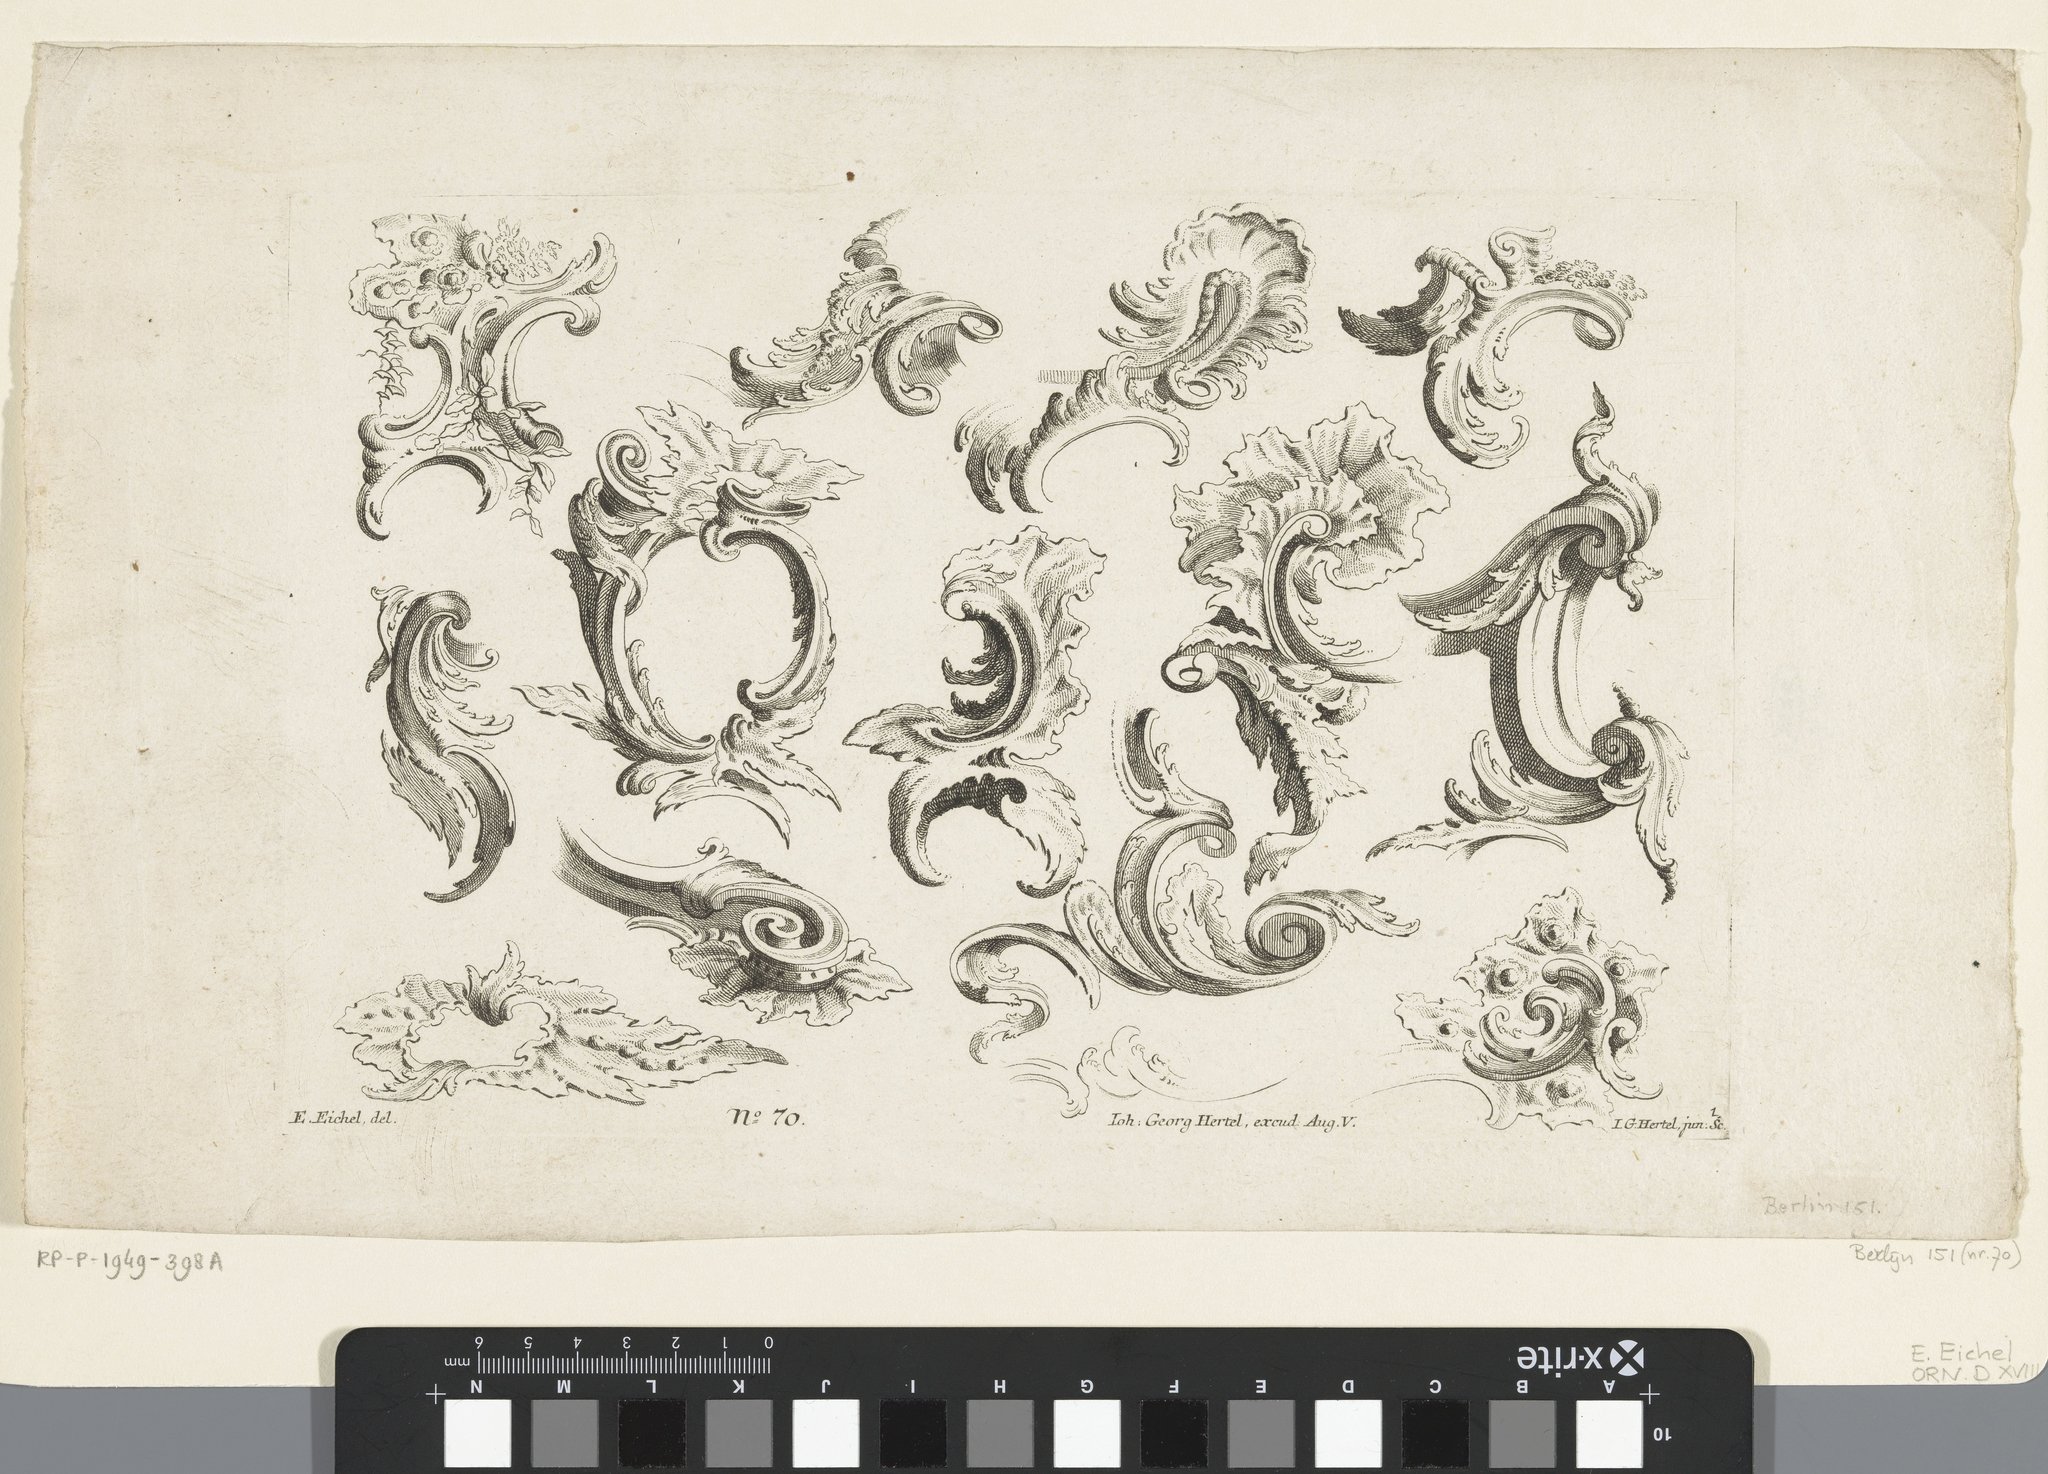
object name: ornament print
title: Voluut- en bladvormige rocaille-ornamenten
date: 1727-1775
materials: paper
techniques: etching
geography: augsburg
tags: rocaille ornament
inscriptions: collector's mark: Lugt 2228